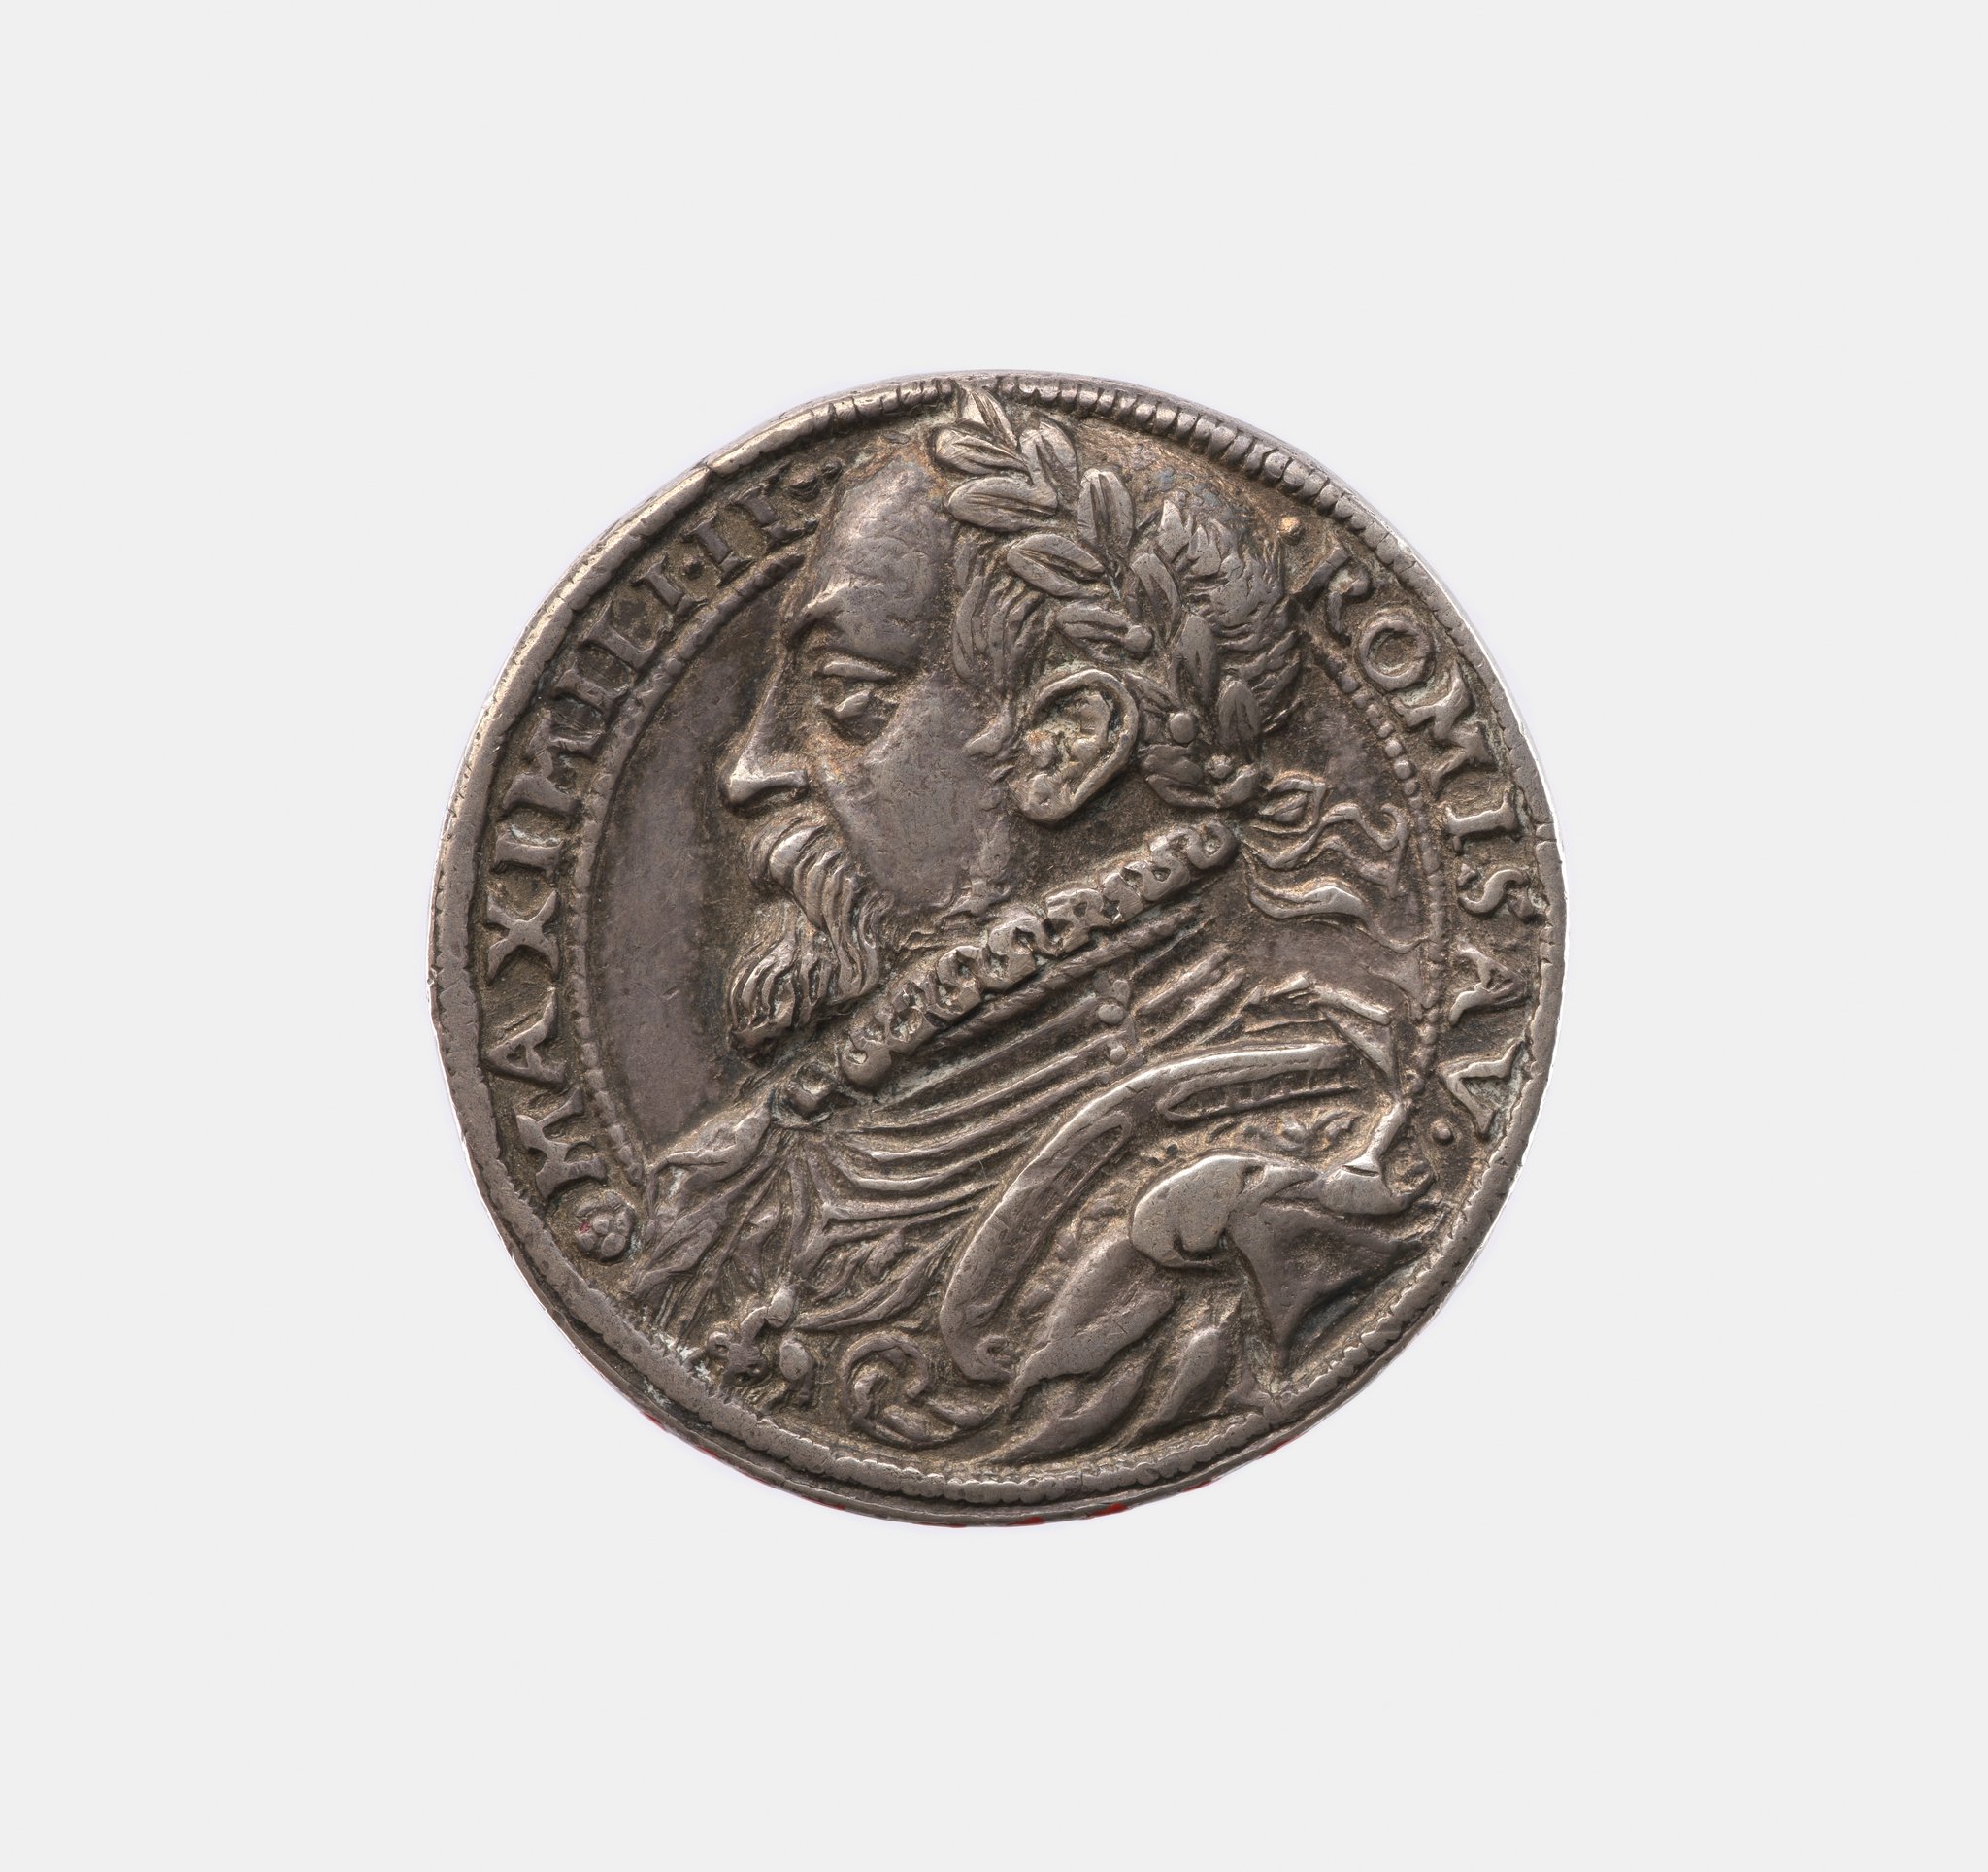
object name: medal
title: Maximilian II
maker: antonio abondio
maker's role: artist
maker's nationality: italian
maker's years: 1538-1591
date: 1570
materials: silver